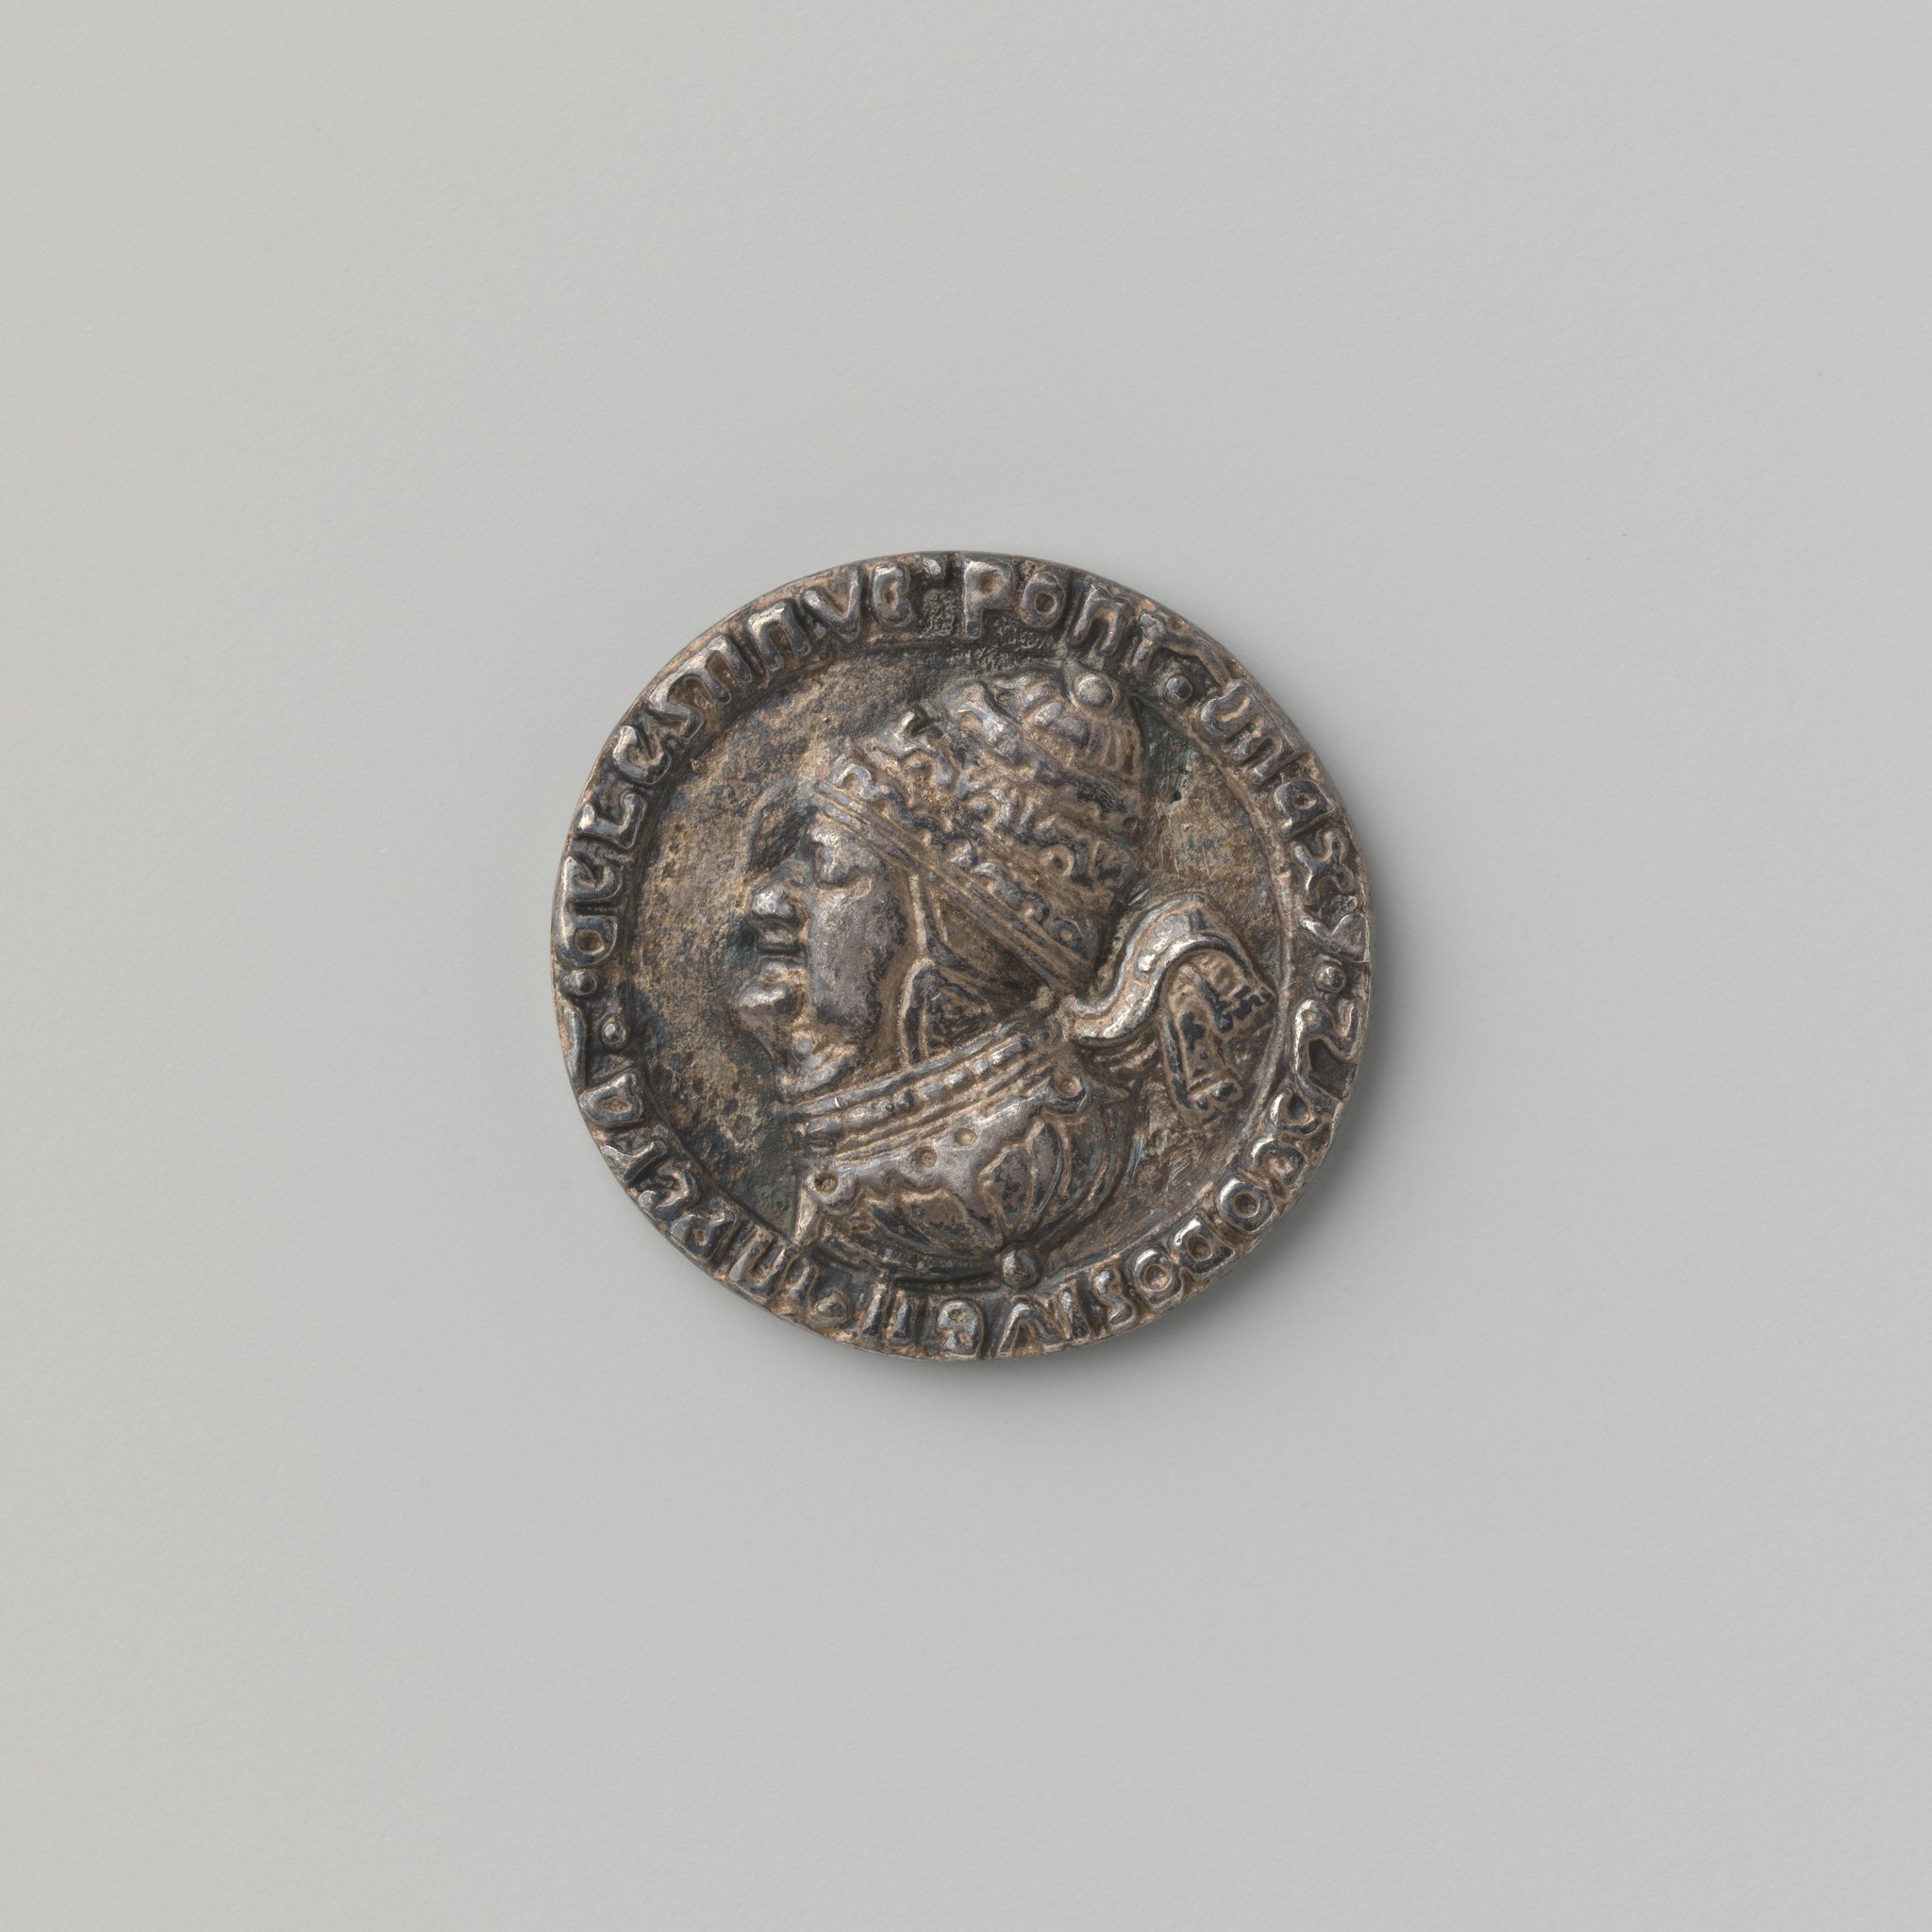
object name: medal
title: Concilie van Trente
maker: Anonymous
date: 1545-1563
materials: silver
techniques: casting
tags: concilie van trente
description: Penning over het Concilie van Trente: paus boven keizer.